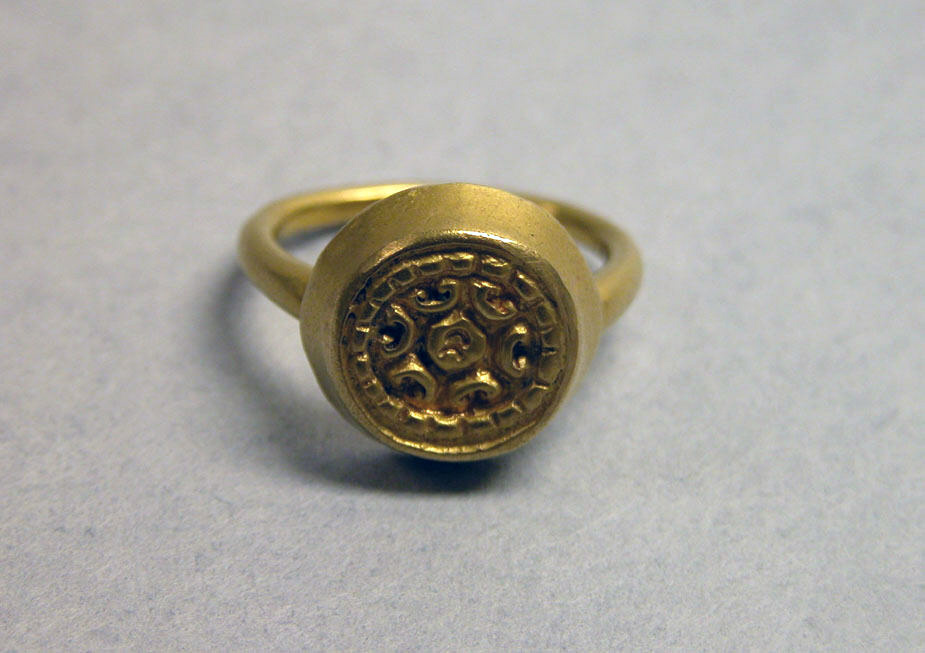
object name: ring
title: Ring with Circular Bezel with Abstract Design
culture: indonesian, javanese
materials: gold